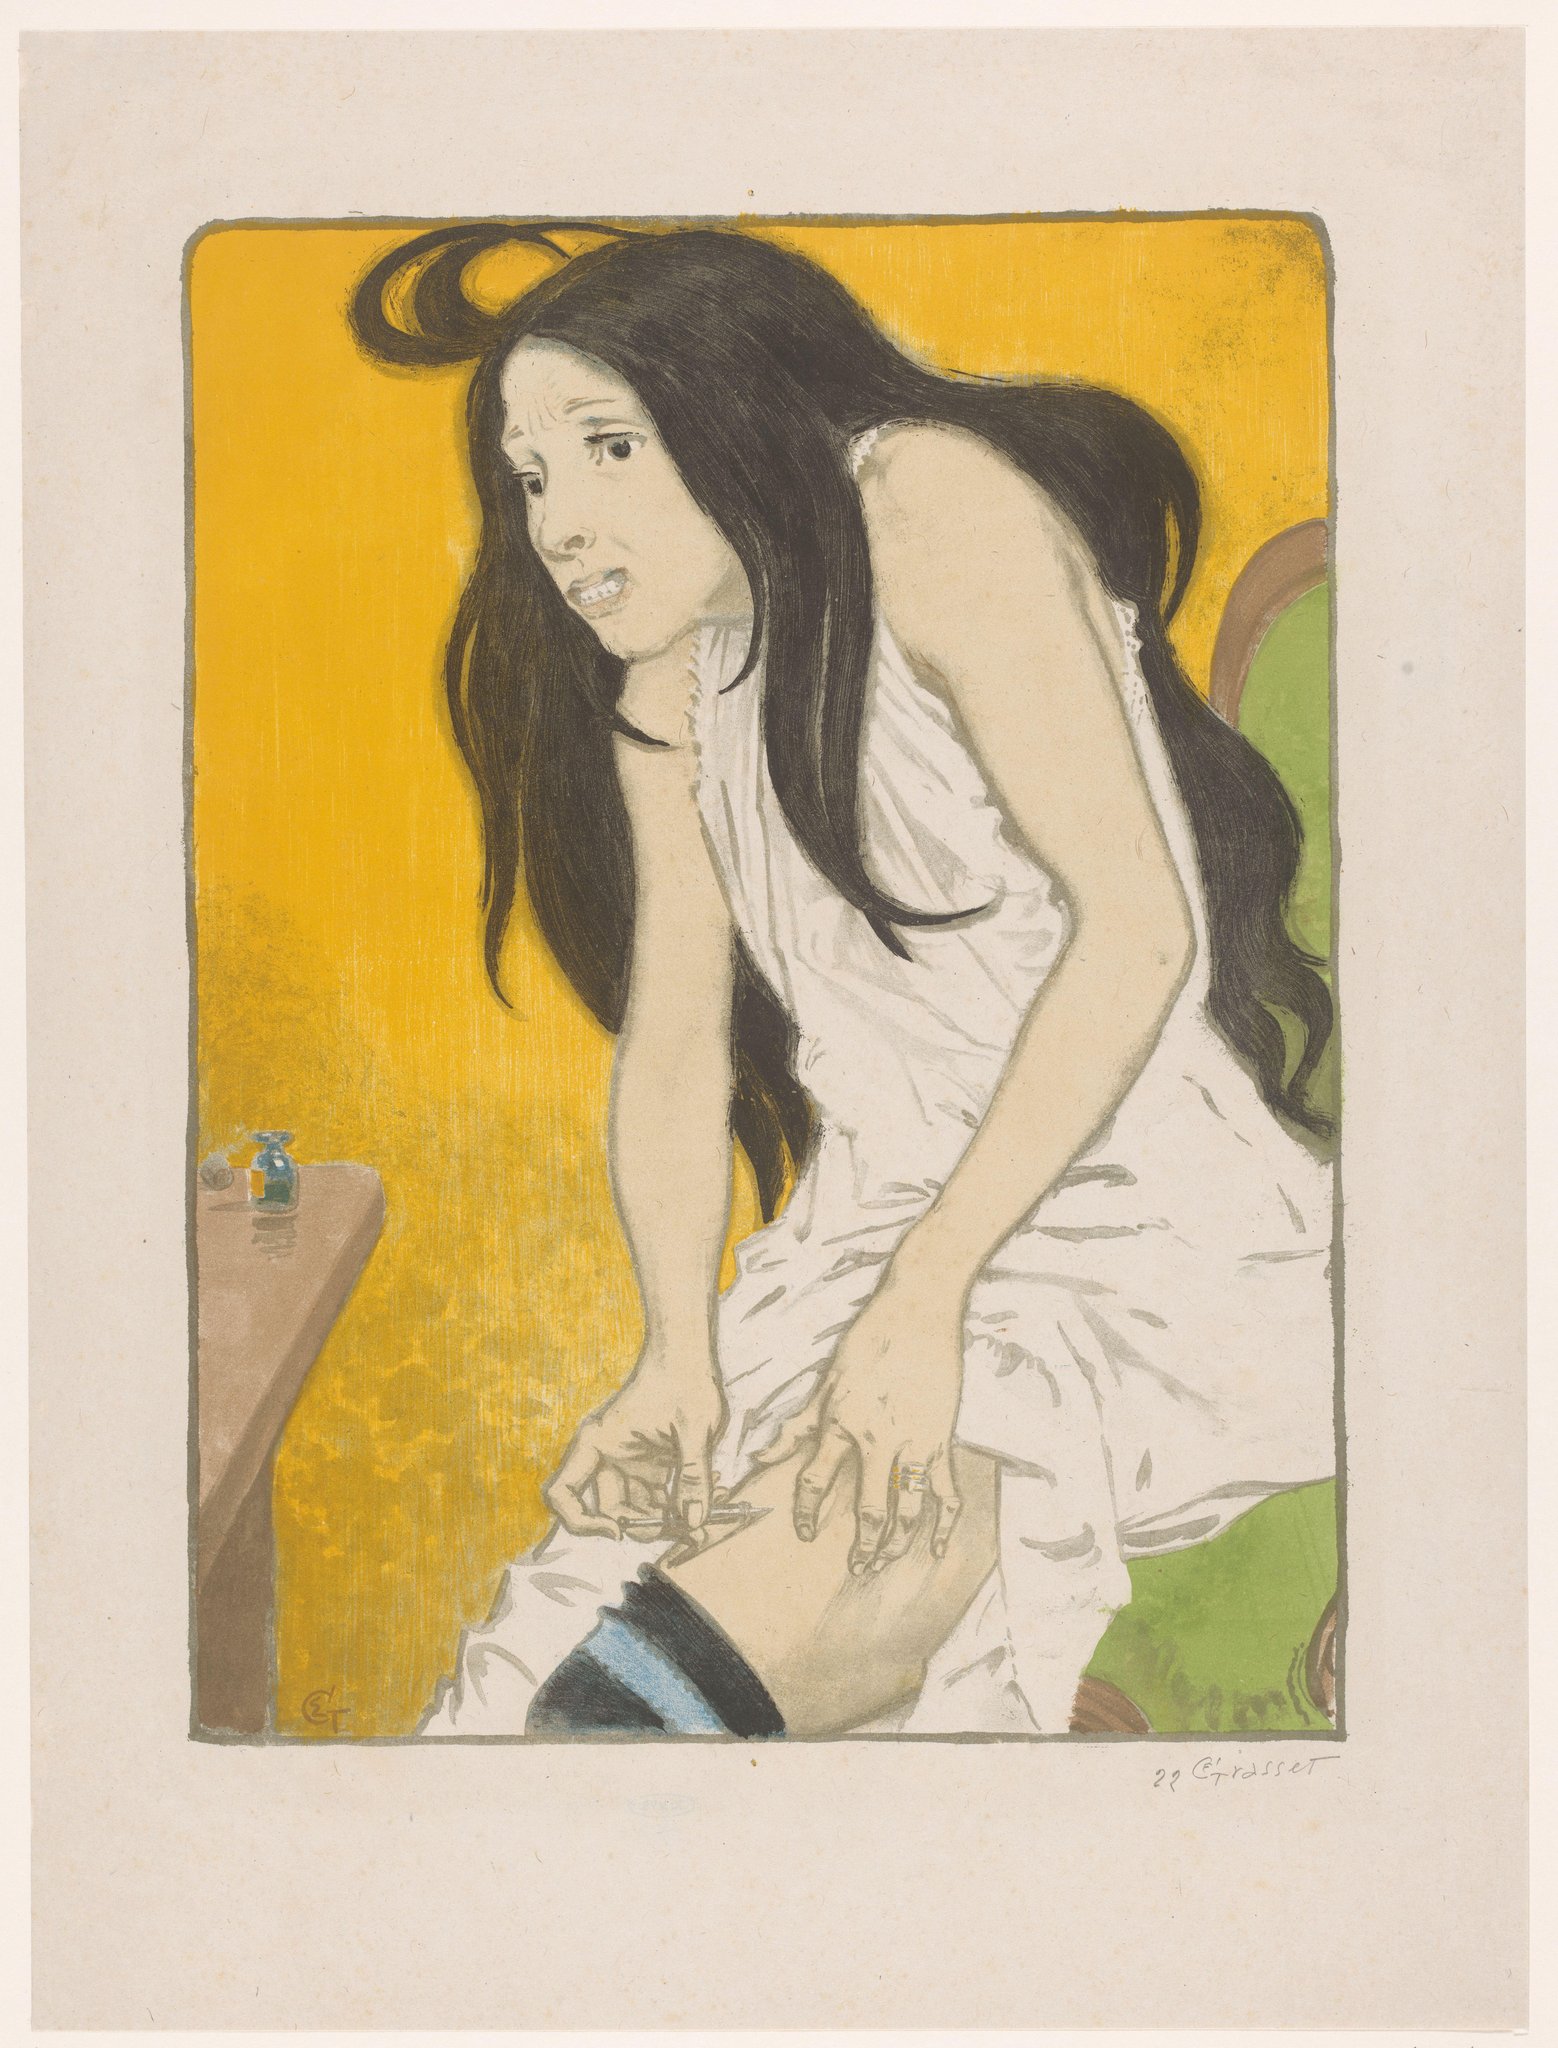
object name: print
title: Morfineverslaafde vrouw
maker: eugène grasset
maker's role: print maker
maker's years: 1841-1917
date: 1897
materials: paper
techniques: lithograph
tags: drugs, addiction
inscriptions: collector's mark: Lugt 2228a